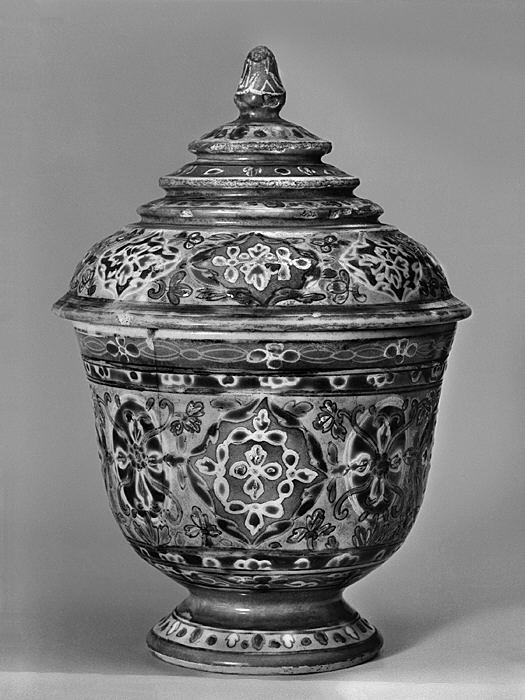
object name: covered bowl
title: Covered bowl with floral patterns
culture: chinese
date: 1801-1900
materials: enamel, porcelain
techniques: overglaze, painting, polychrome